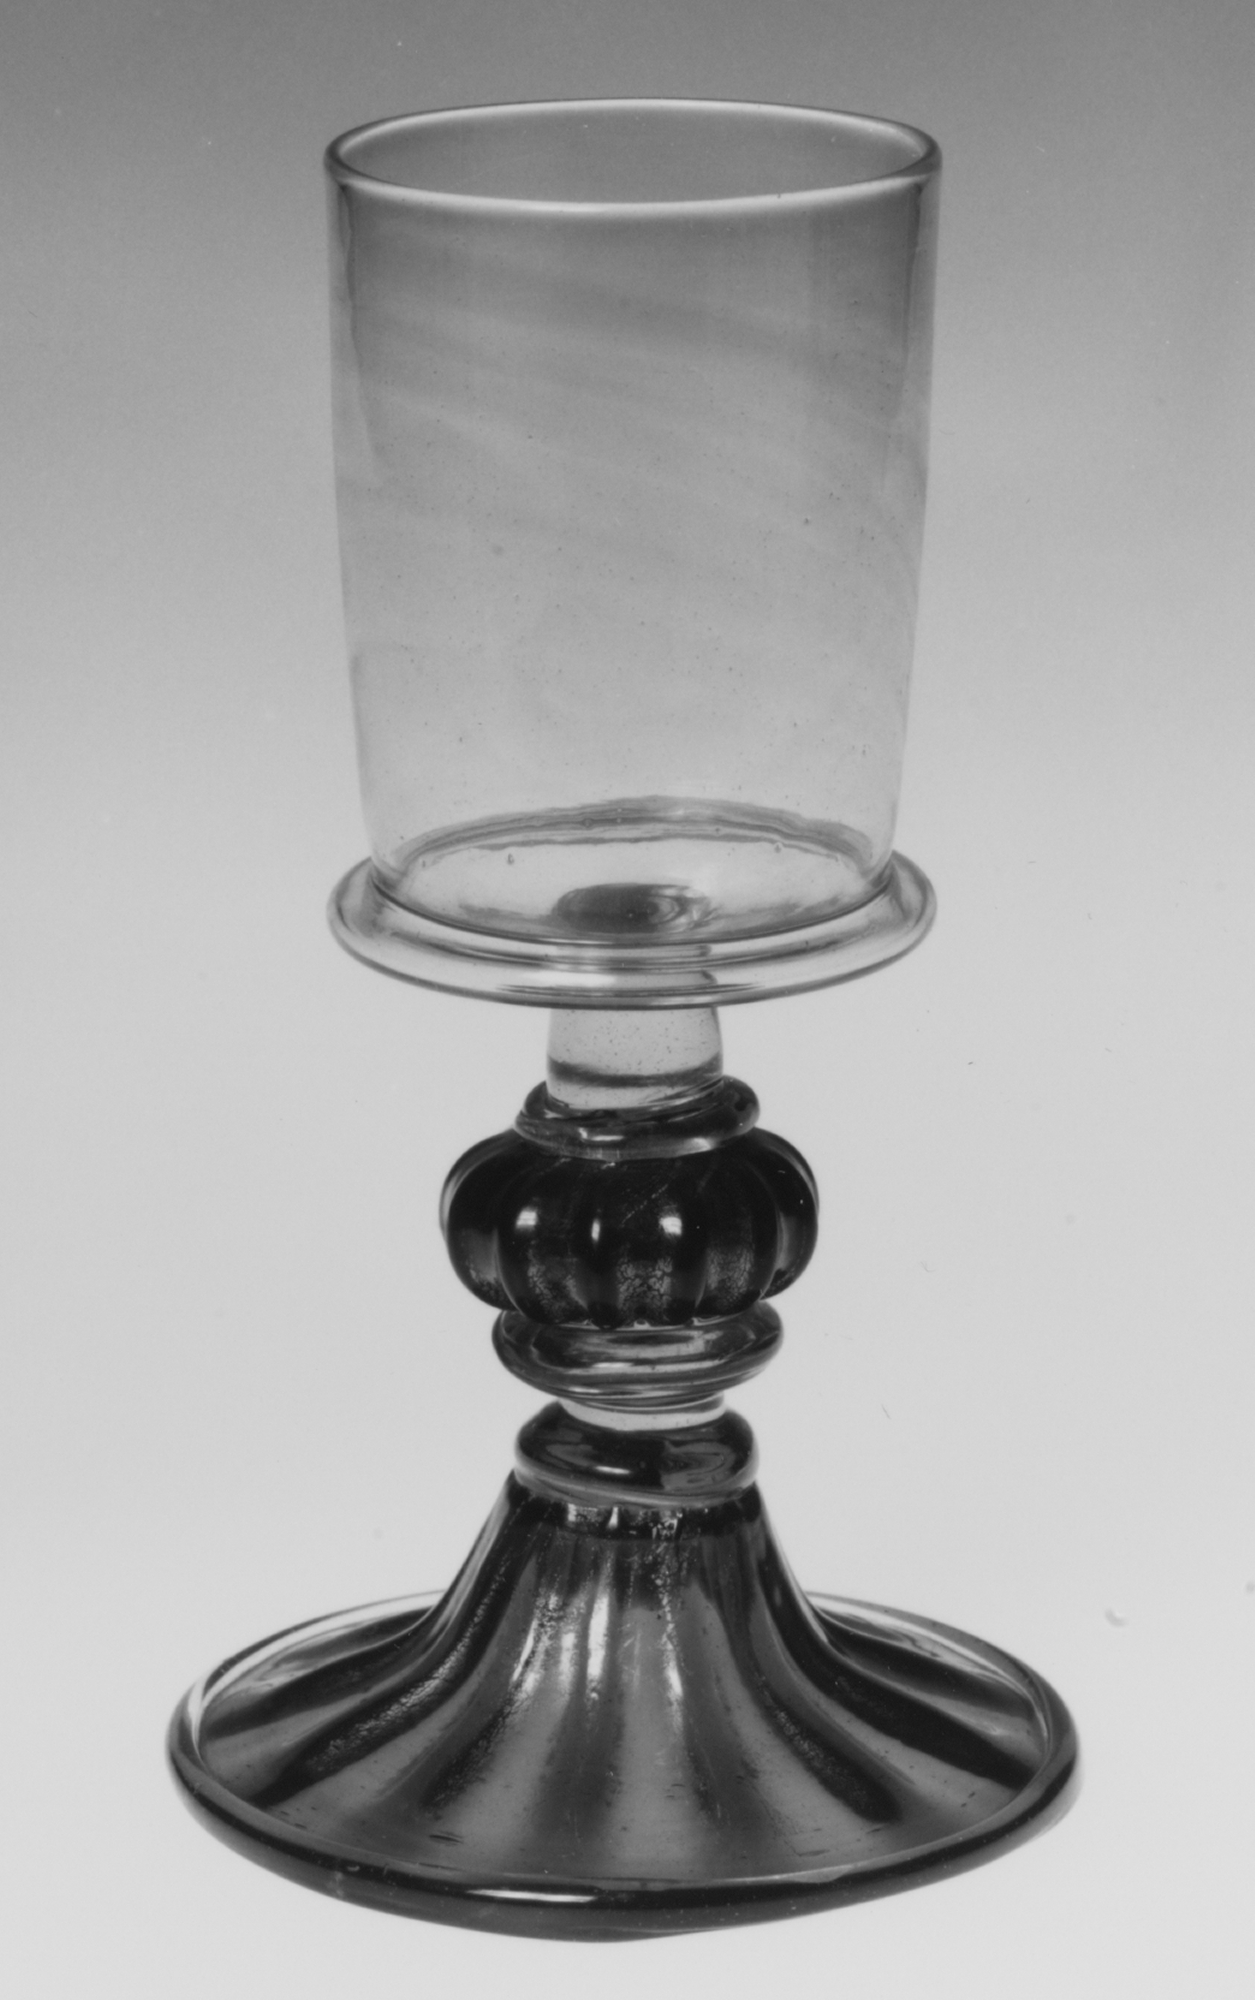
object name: goblet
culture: italian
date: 1500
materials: gilt, glass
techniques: glassblowing, molding